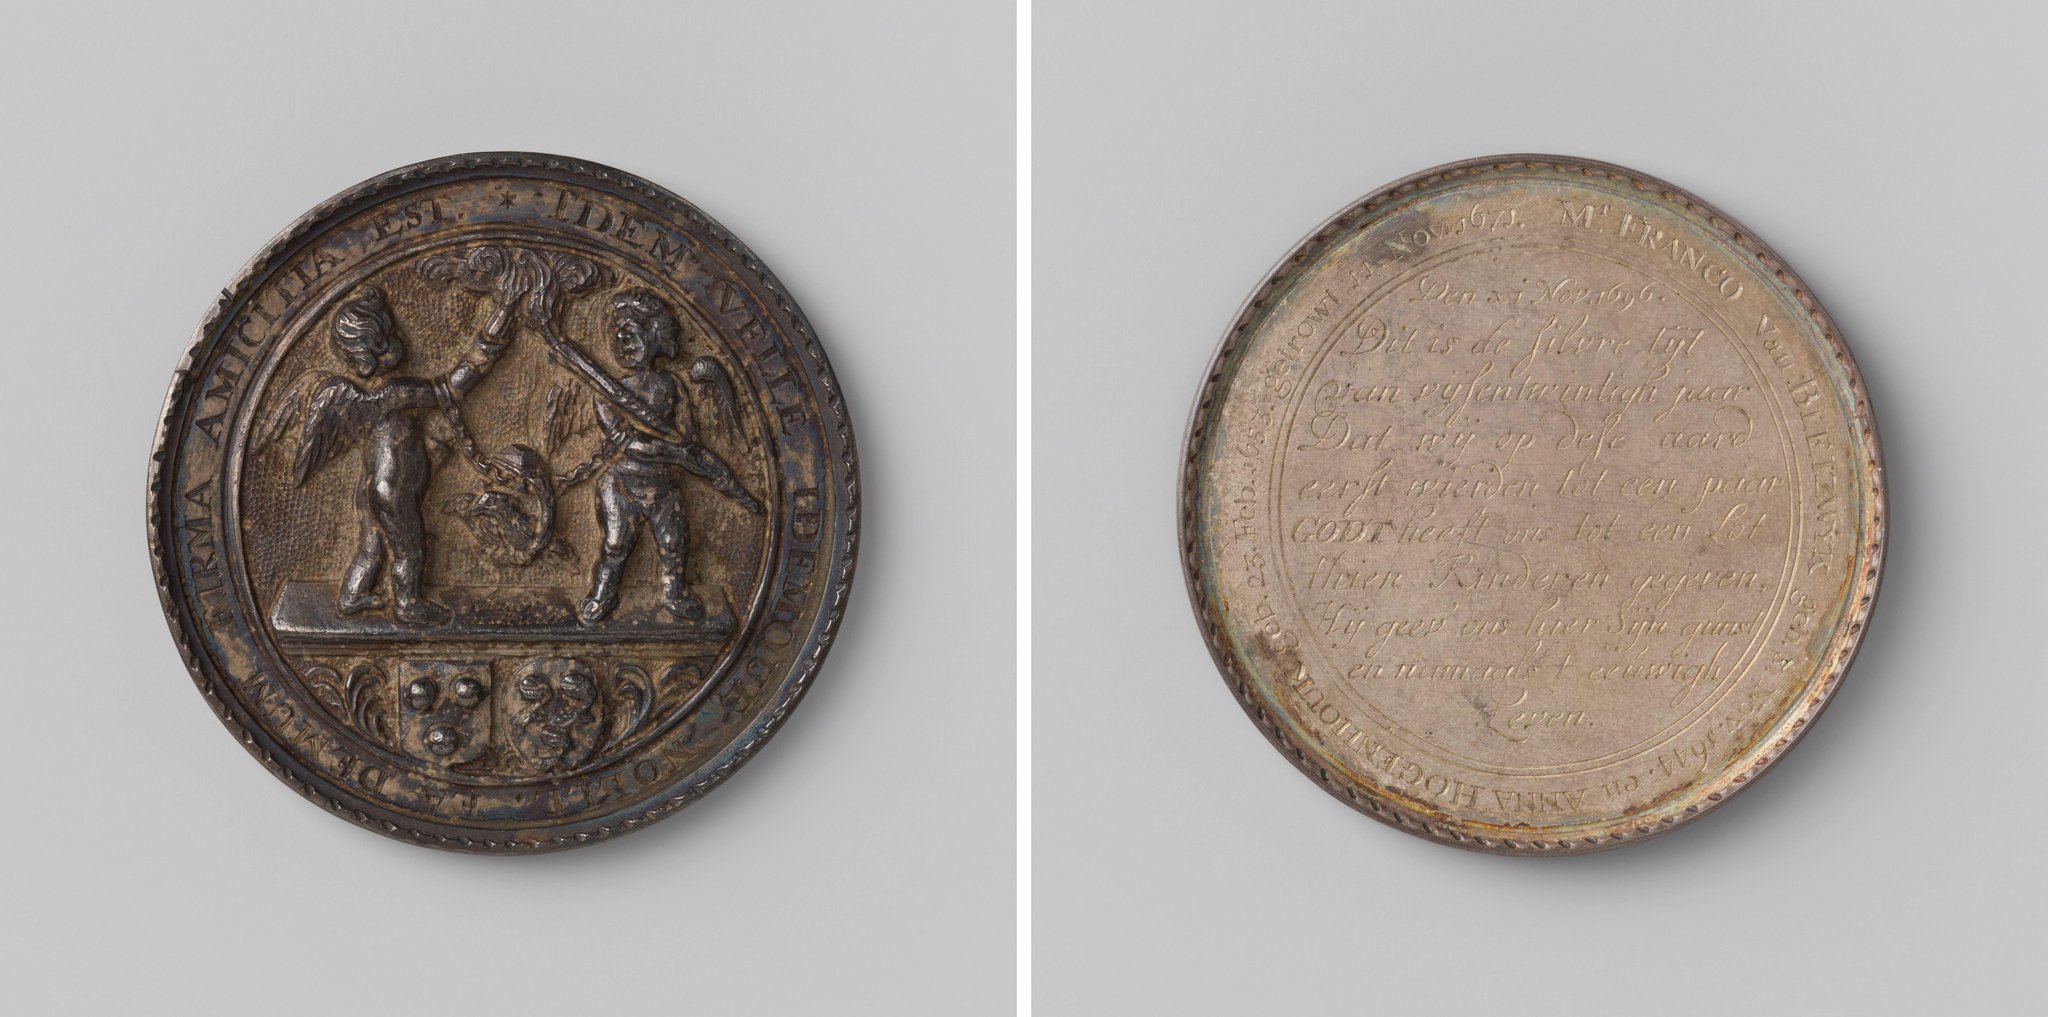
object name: family medal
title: Vijfentwintigjarig huwelijk van Franco van Bleizwijk en Anna Hogenhouk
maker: Anonymous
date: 1696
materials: silver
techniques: casting, engraving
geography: netherlands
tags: franco van bleiswijck, anna hogenhouk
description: Zilveren penning. Voorzijde: twee engeltjes met fakkel dragen samen een ketting, waaraan ring hangt met twee duifjes erin boven twee wapenschilden binnen omschrift. Keerzijde: opschrift binnen omschrift